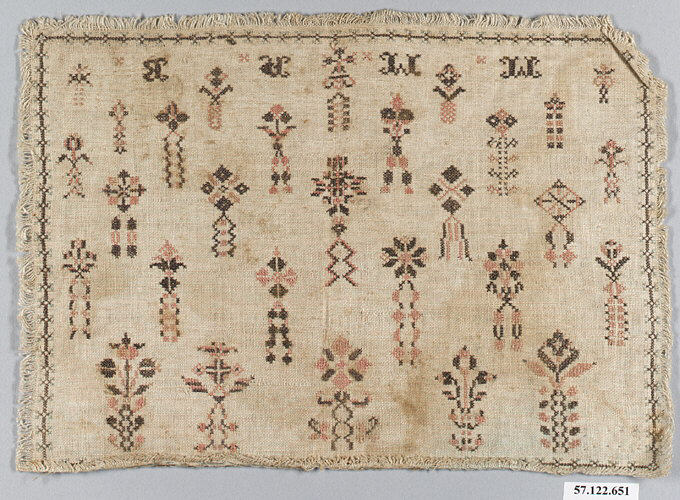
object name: sampler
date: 1801-1900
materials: linen, silk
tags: flowers